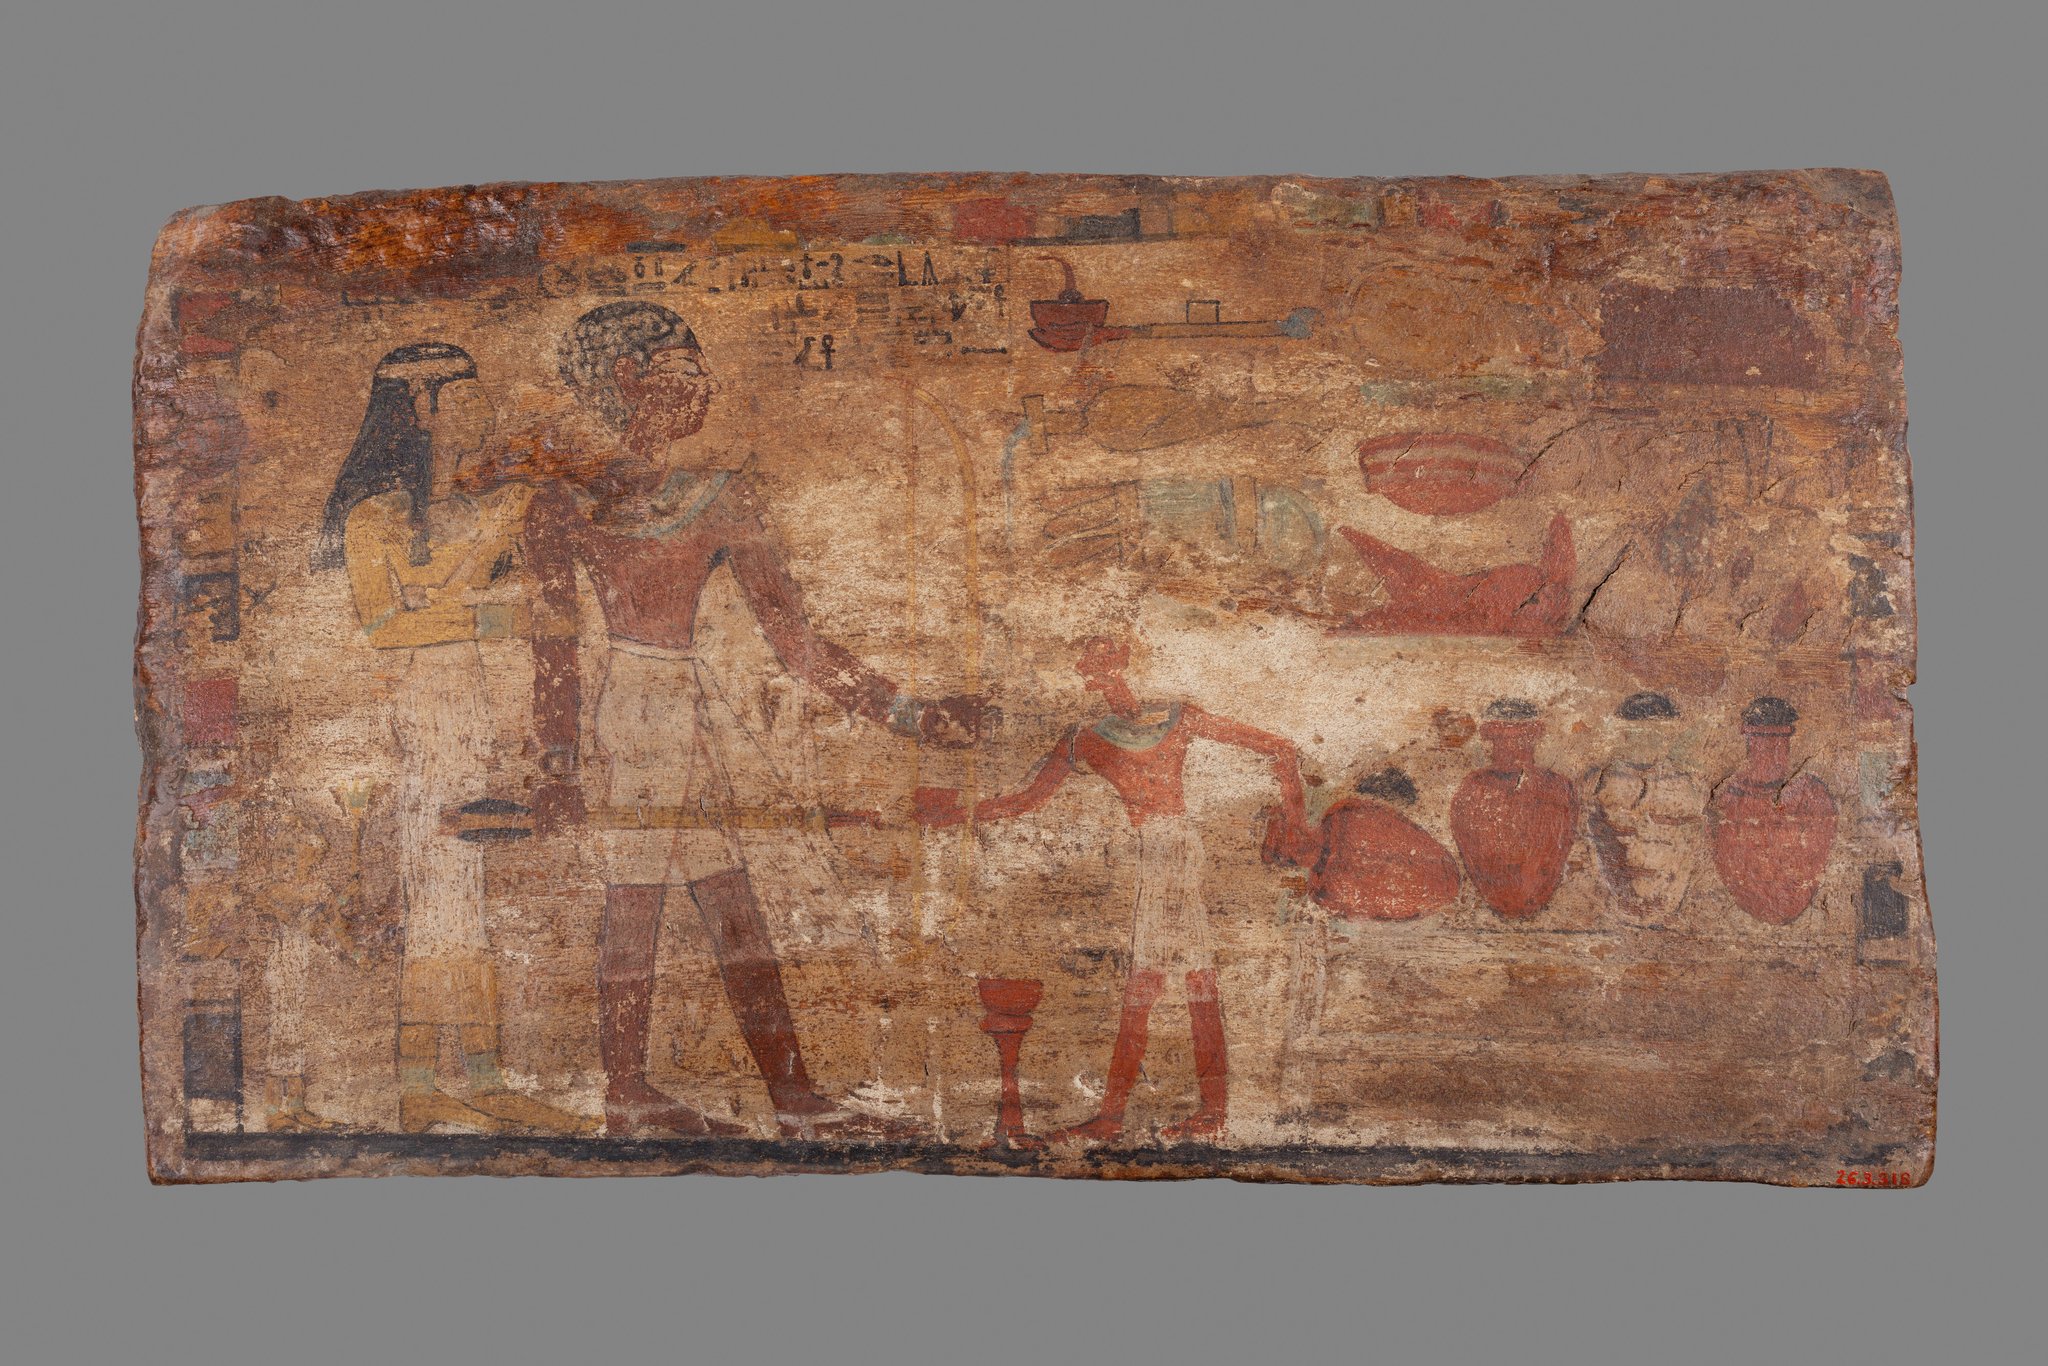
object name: writing board, stela, mentuhotep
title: Writing board stela of Mentuhotep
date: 2030-1652 BCE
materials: paint, wood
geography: egypt